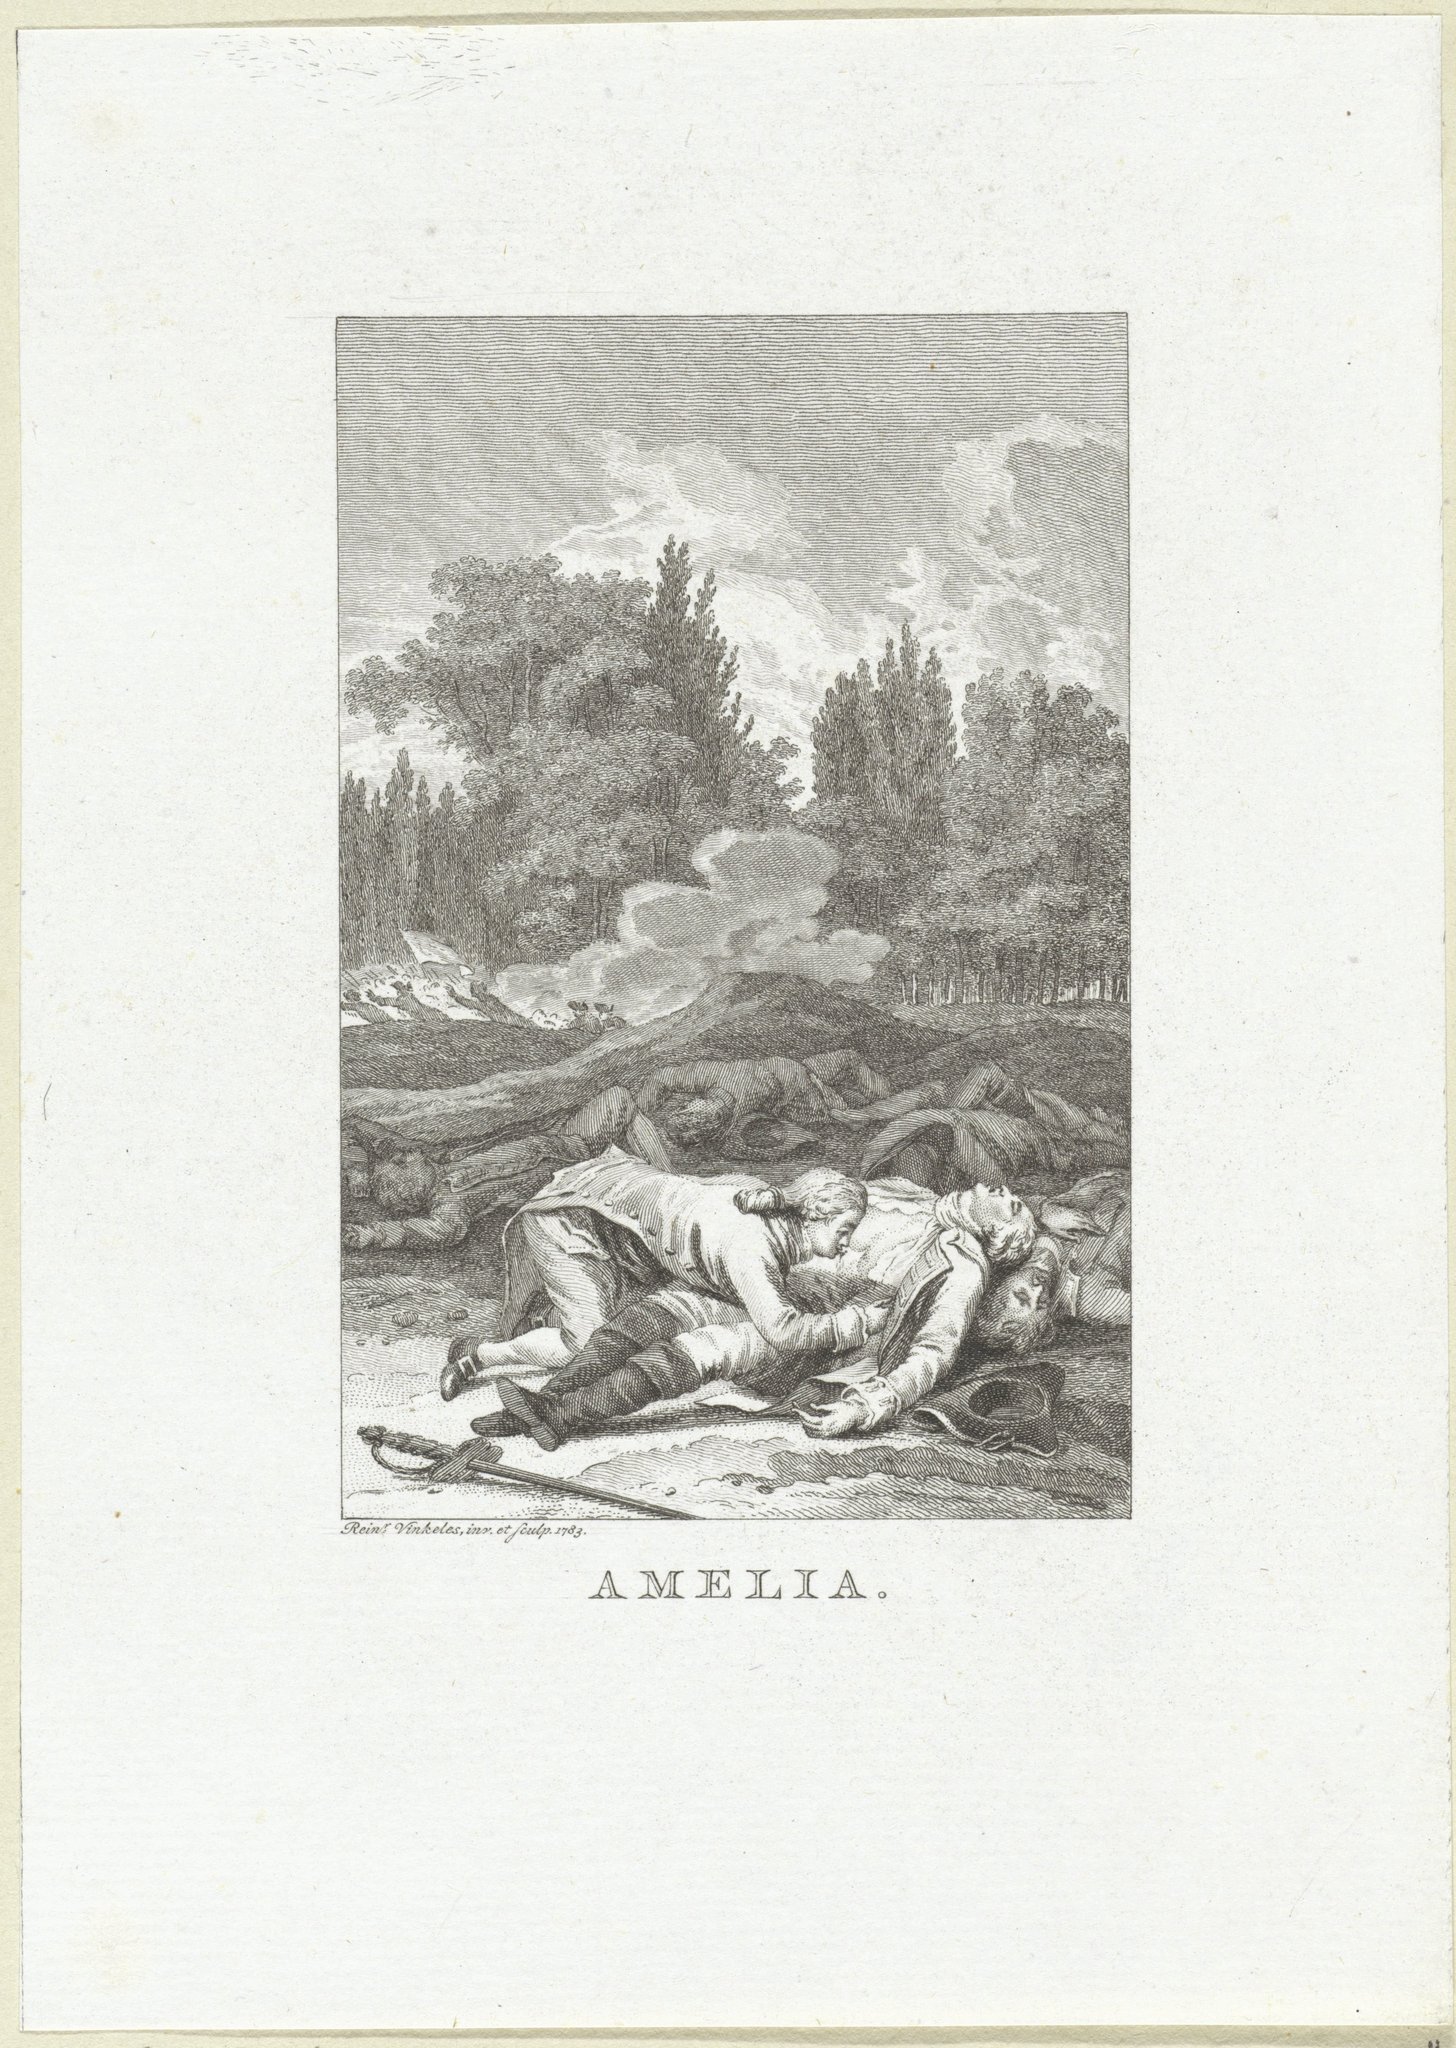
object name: print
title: Slagveld in een bos met een man die zijn hoofd op de borst van een gesneuvelde soldaat legt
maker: reinier vinkeles (i)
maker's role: draughtsman, print maker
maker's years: 1741-1816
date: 1783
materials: paper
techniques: engraving, etching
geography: amsterdam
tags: horrors of war (+ land forces), forest, wood, violent death, being killed; being mishandled and maltreated; seeking death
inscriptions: collector's mark: Lugt 240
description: Deze prent is ook gebruikt als illustratie bij het verhaal 'Amelia' voor: Baculard d'Arnaud, F.T.M. de. Zedelijke verhaalen, deel 8. Amsterdam: A. Mens Jansz., 1783.